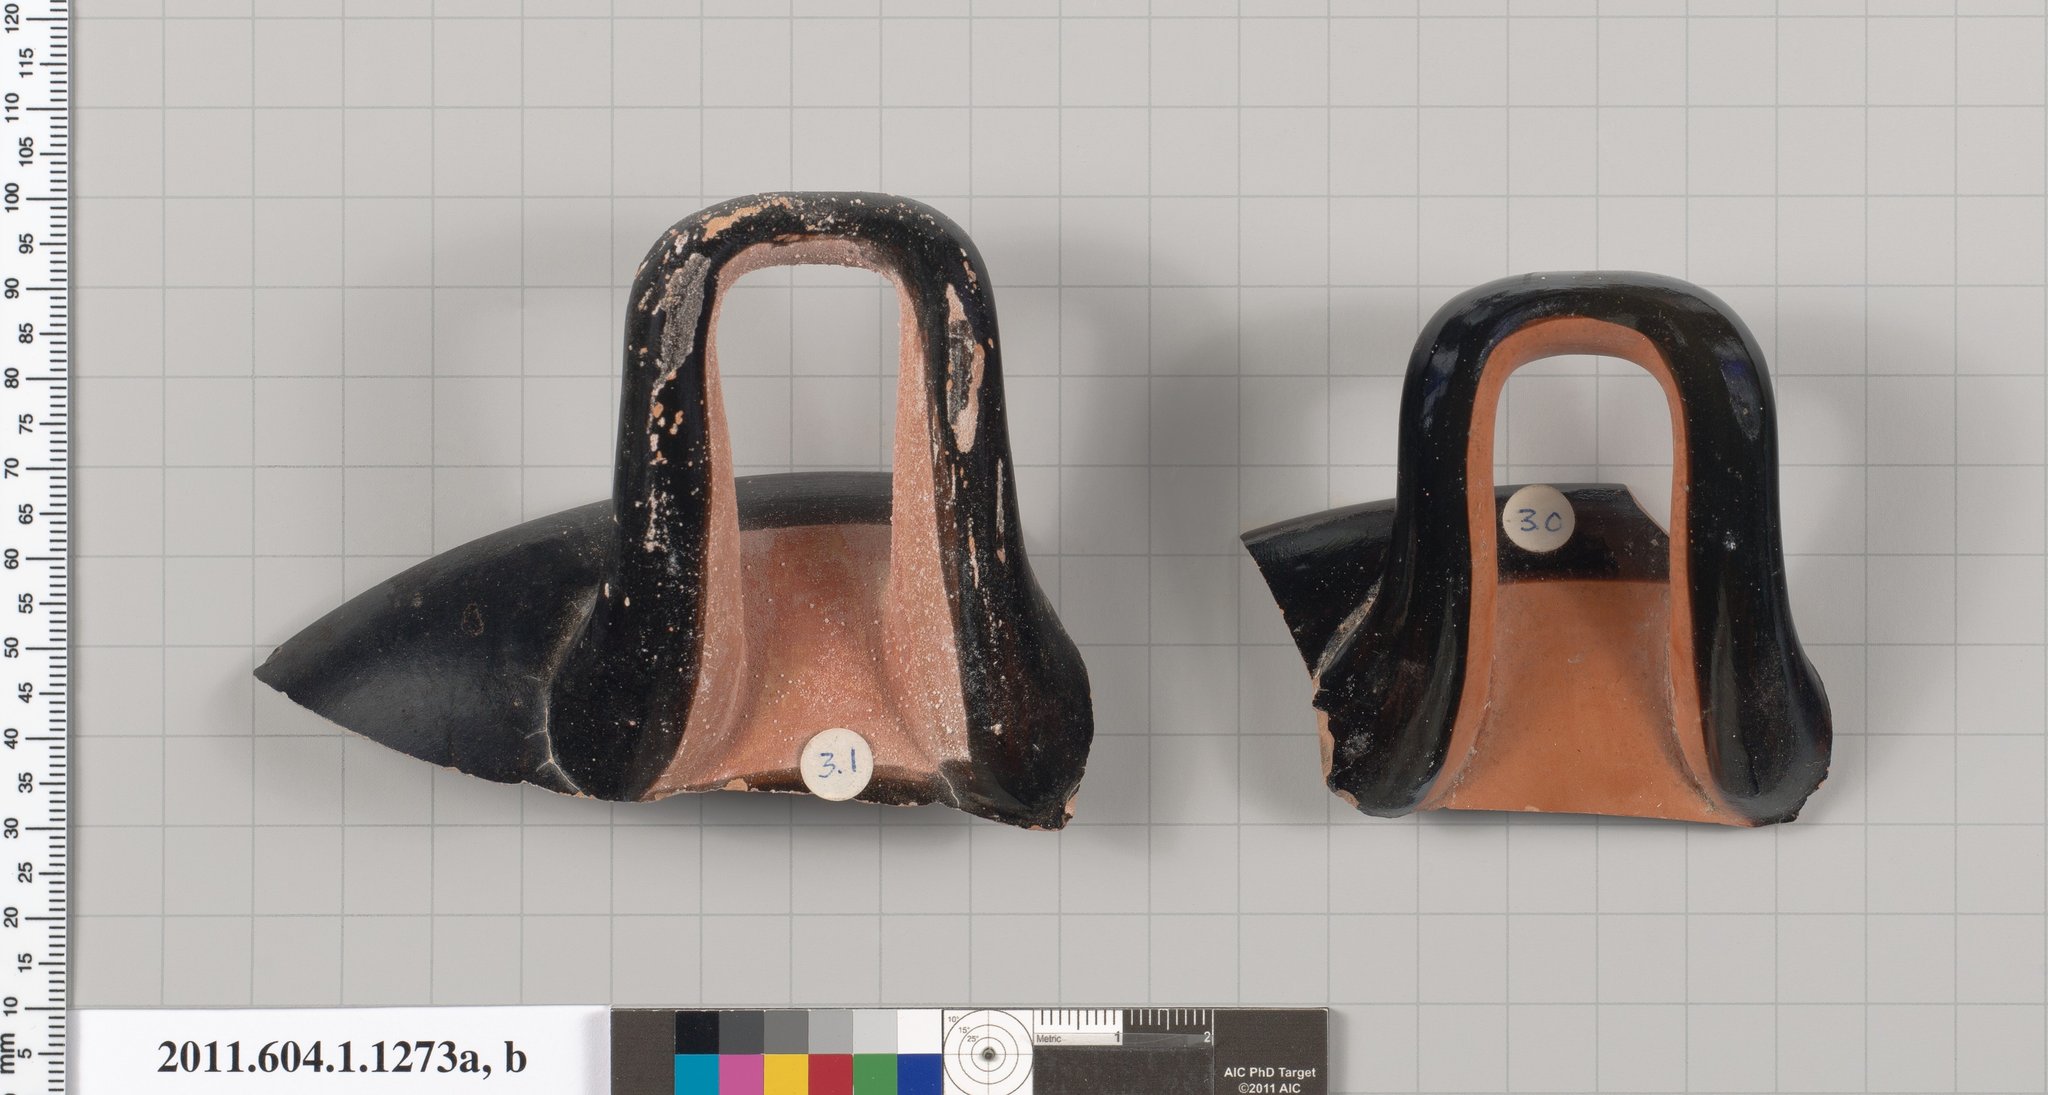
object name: kylix fragment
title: Terracotta fragments of kylikes (drinking cups)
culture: greek, attic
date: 500-401 BCE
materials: terracotta